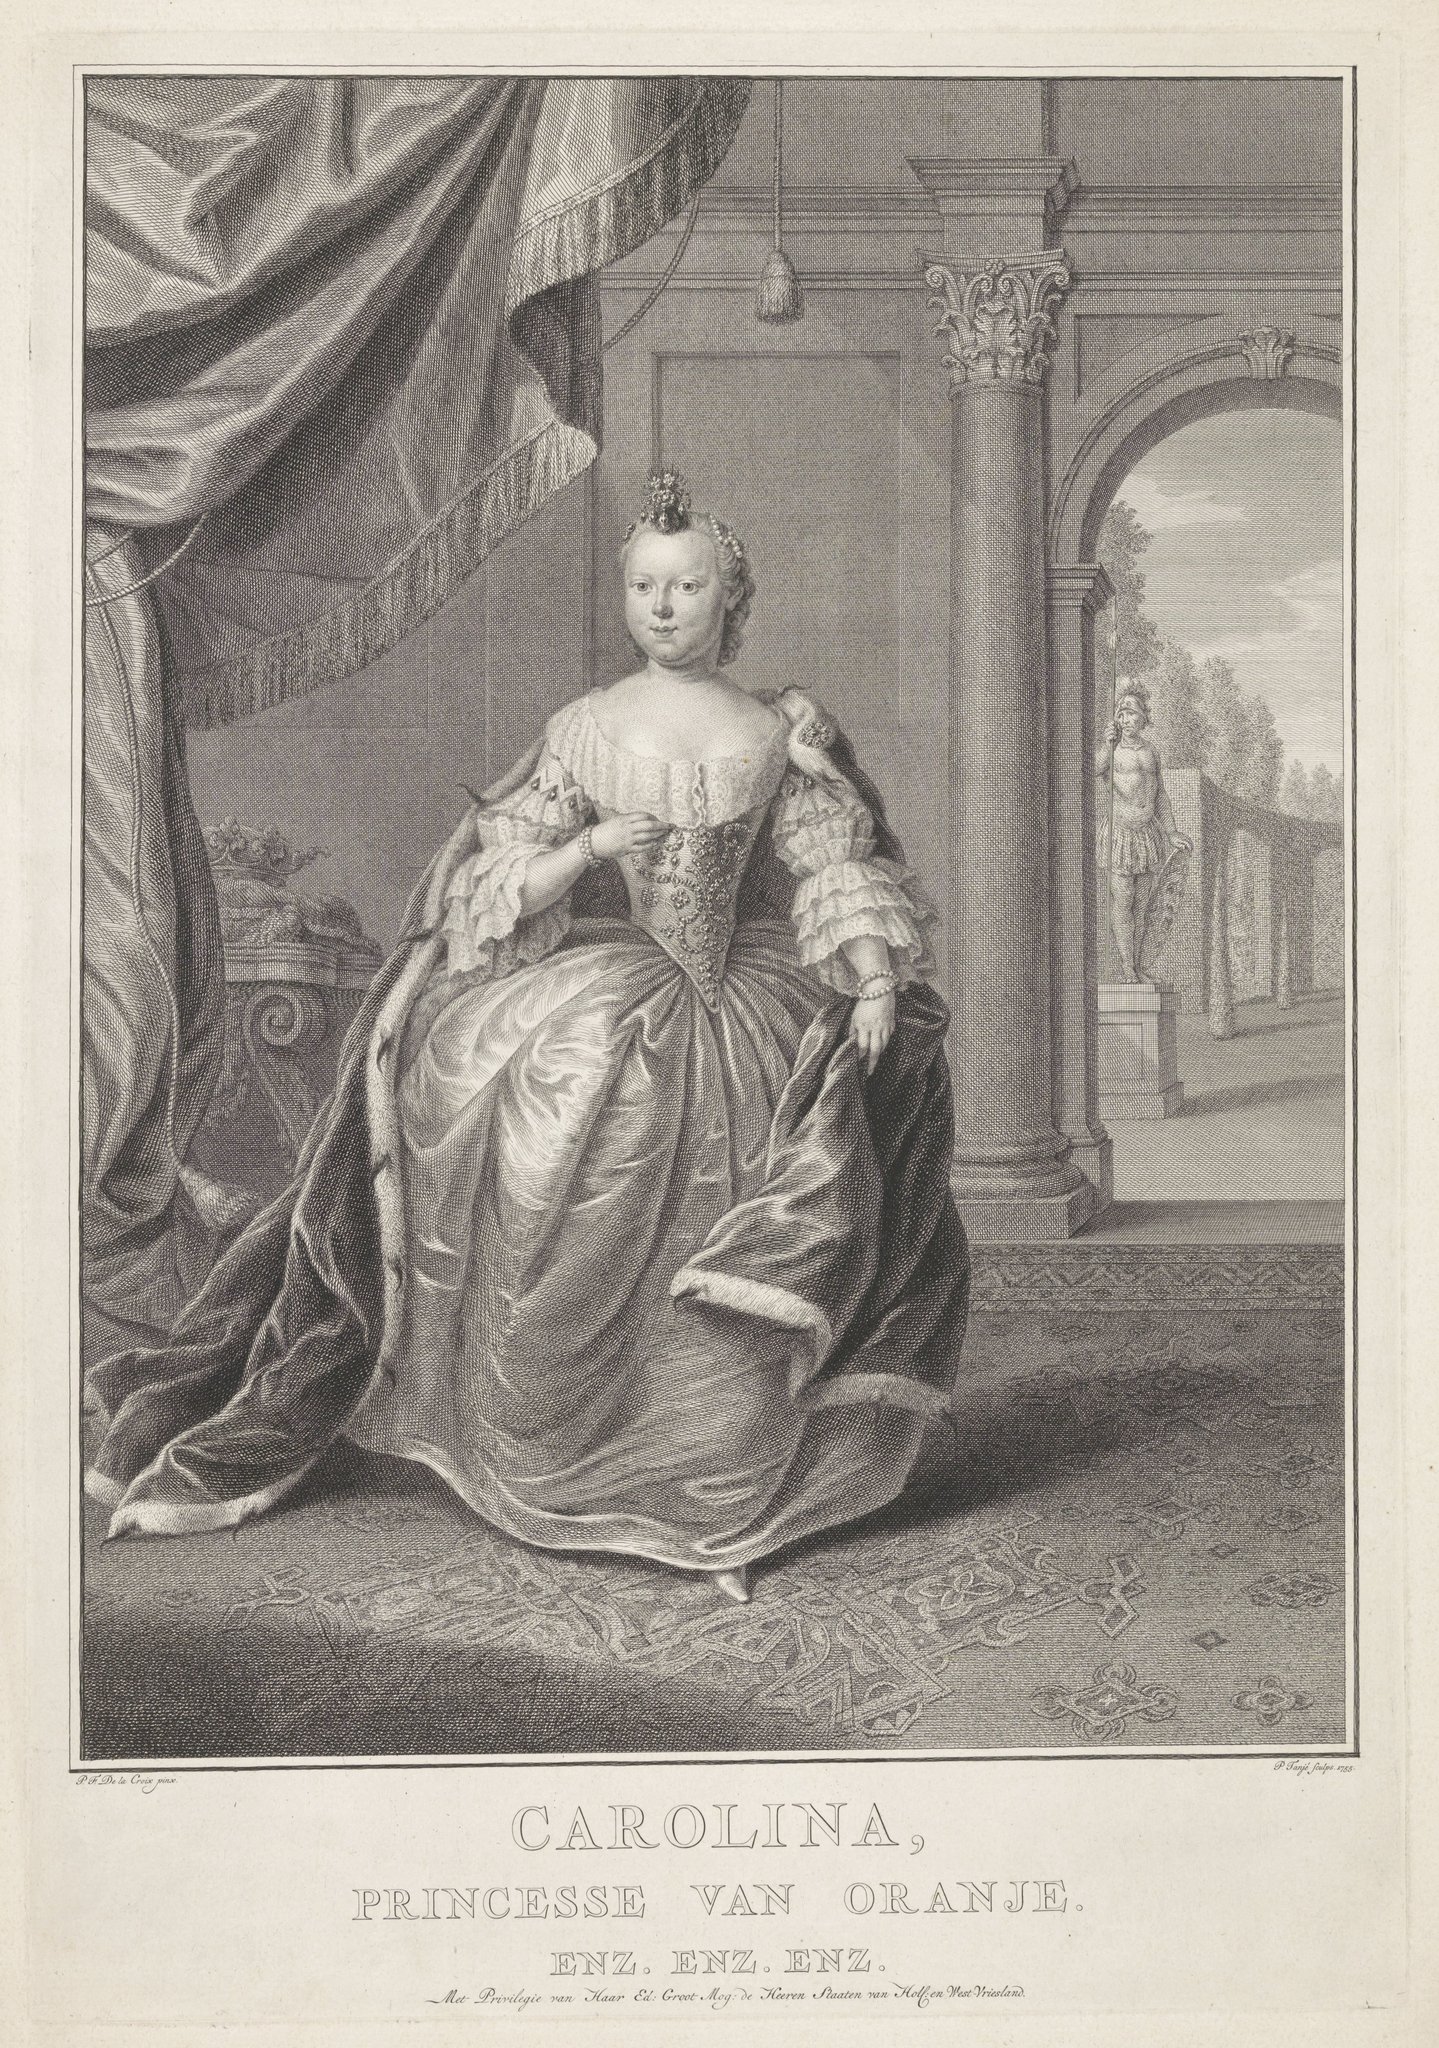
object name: print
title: Portret van Carolina, prinses van Oranje-Nassau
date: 1755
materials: paper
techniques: engraving, etching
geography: amsterdam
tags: carolina (prinses van oranje-nassau)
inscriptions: date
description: De hier vermelde titel verwijst naar de hoogst verkregen titel van de geportretteerde, niet per se naar de titel die de geportretteerde op deze voorstelling draagt.